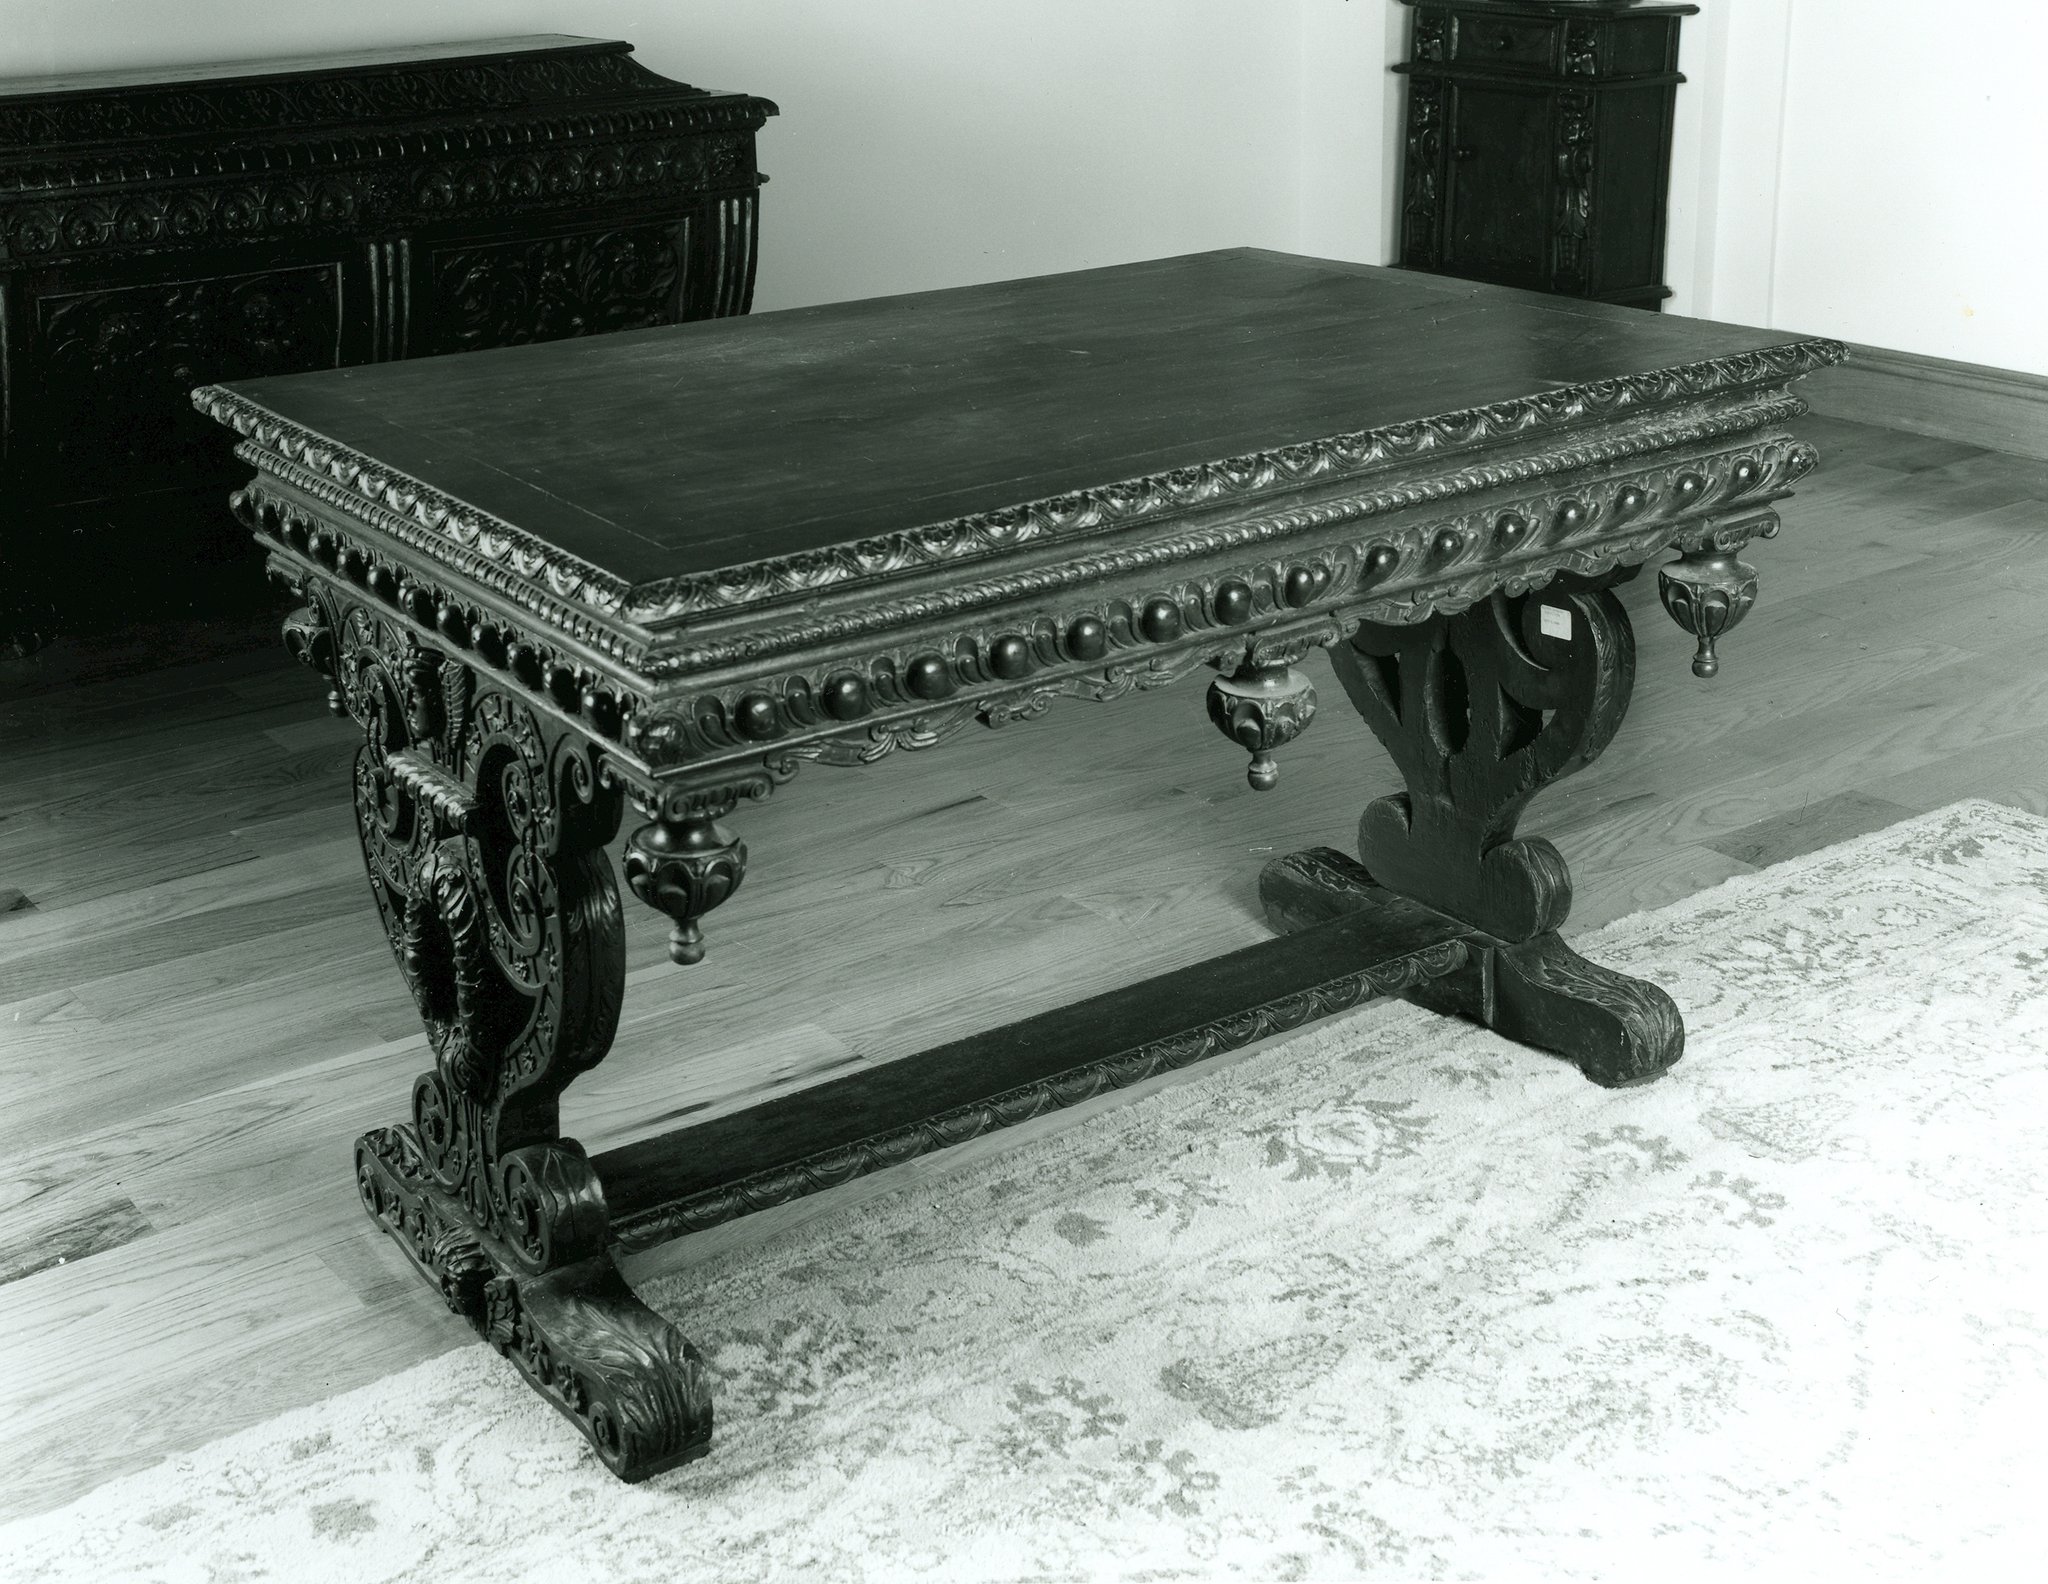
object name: table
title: Center table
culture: french or italian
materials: wood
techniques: carving